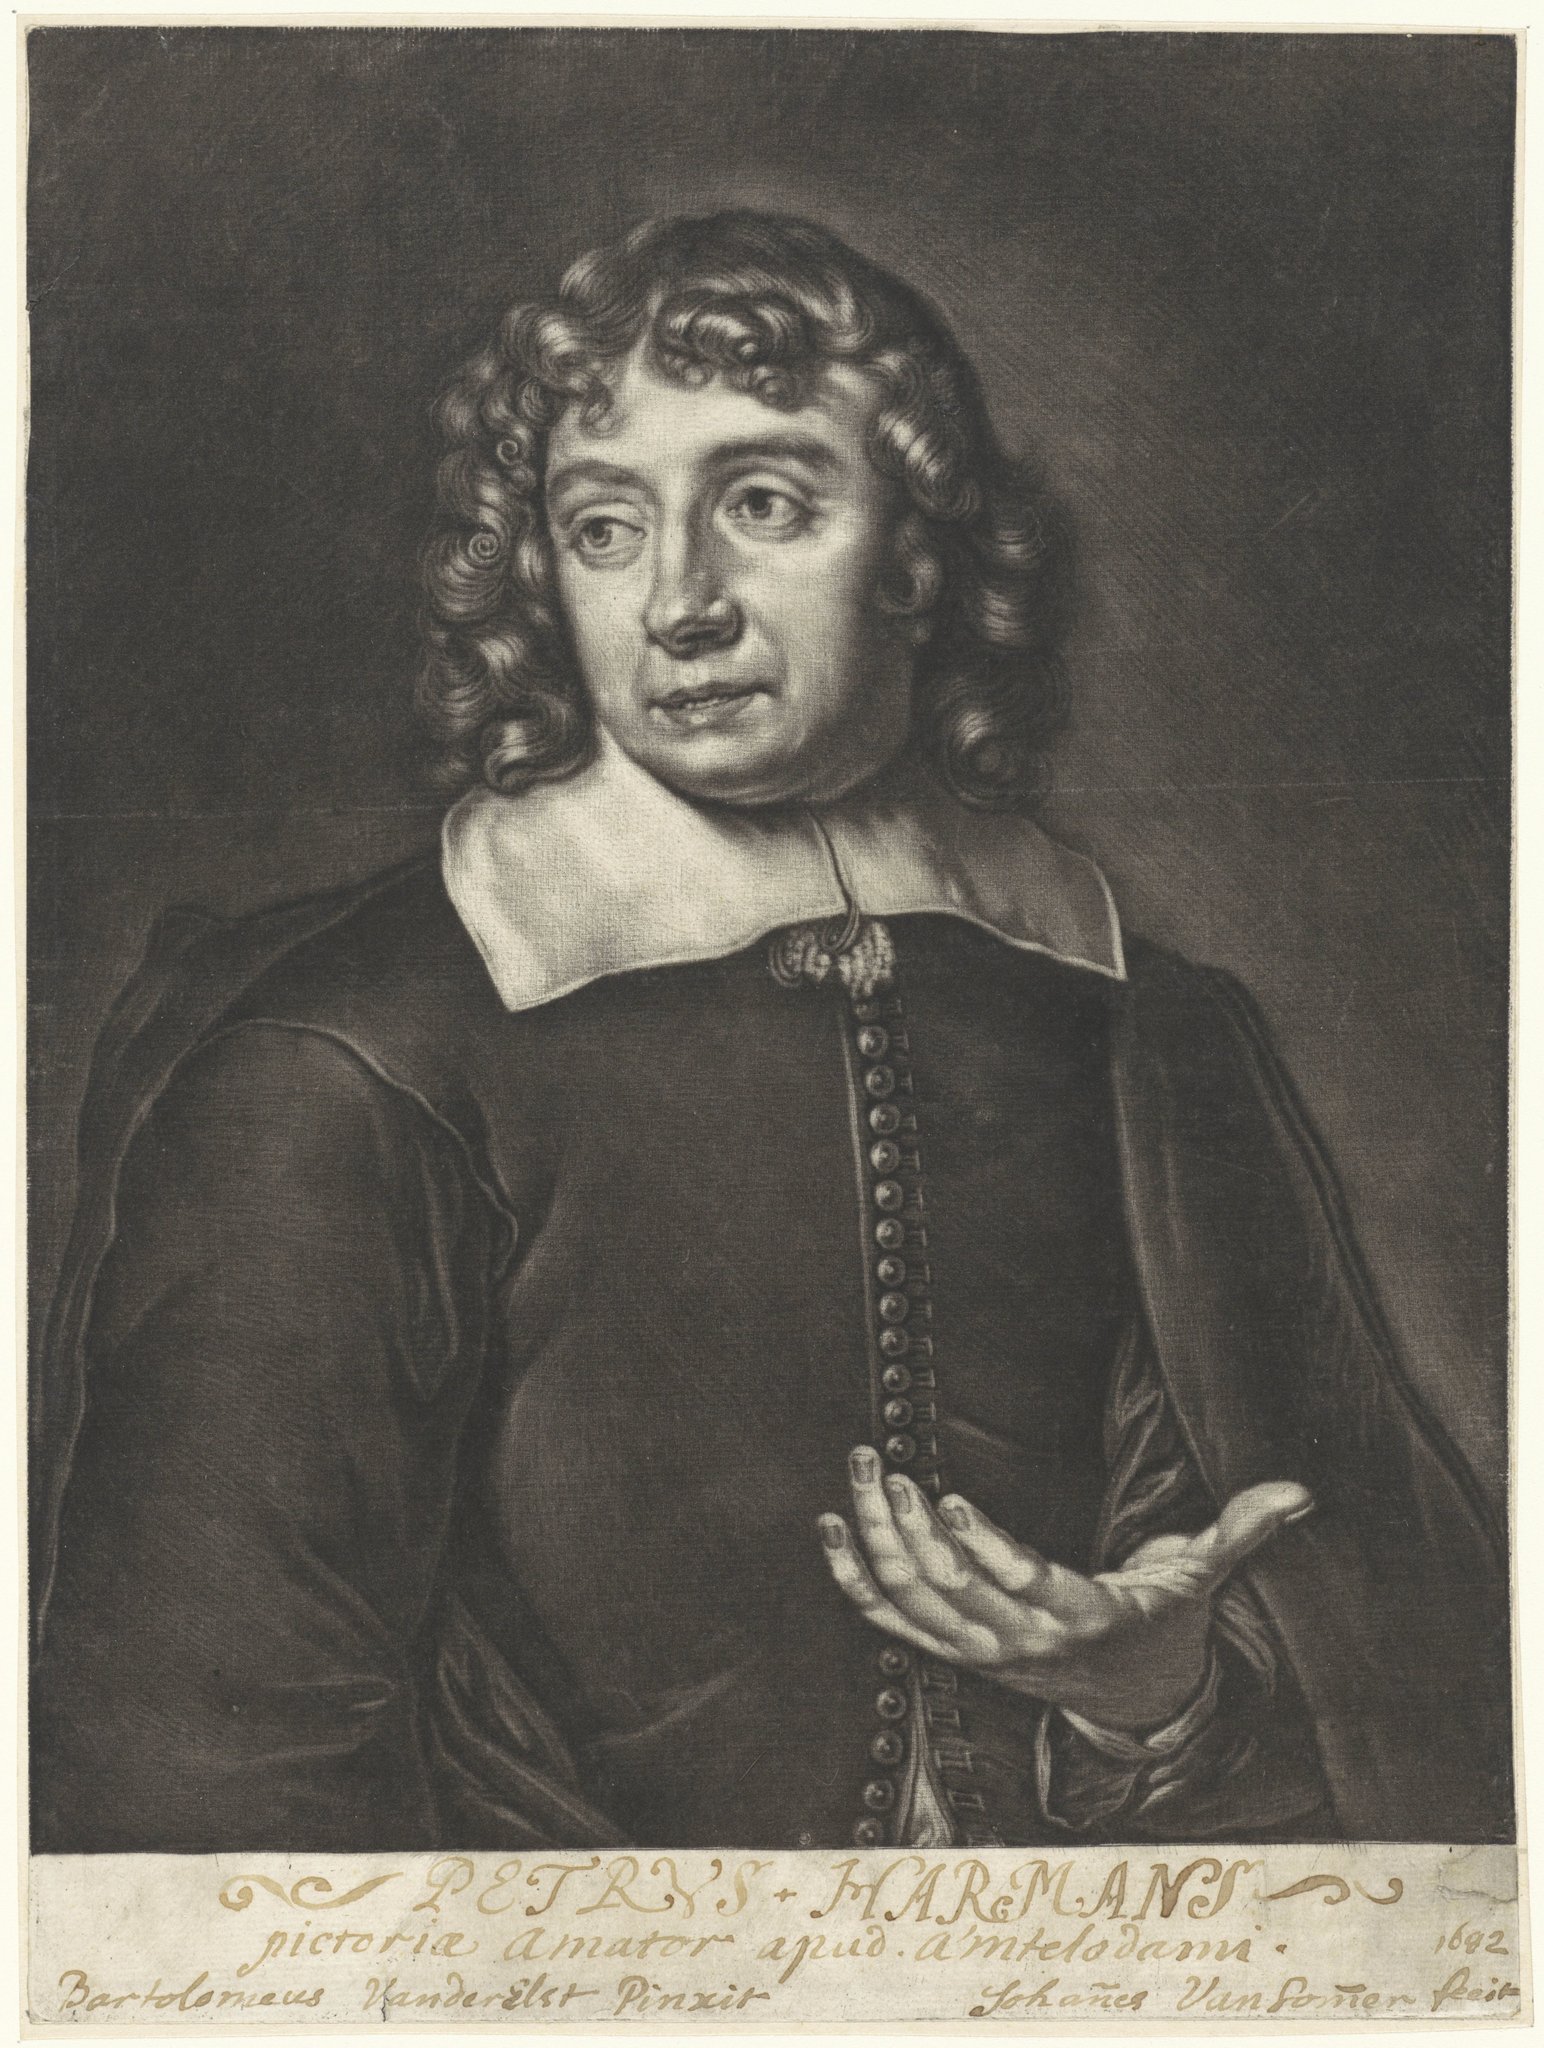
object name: print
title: Portret van Petrus Harmans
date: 1692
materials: paper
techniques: mezzotint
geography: amsterdam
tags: petrus harmans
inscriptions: collector's mark: Lugt 2228